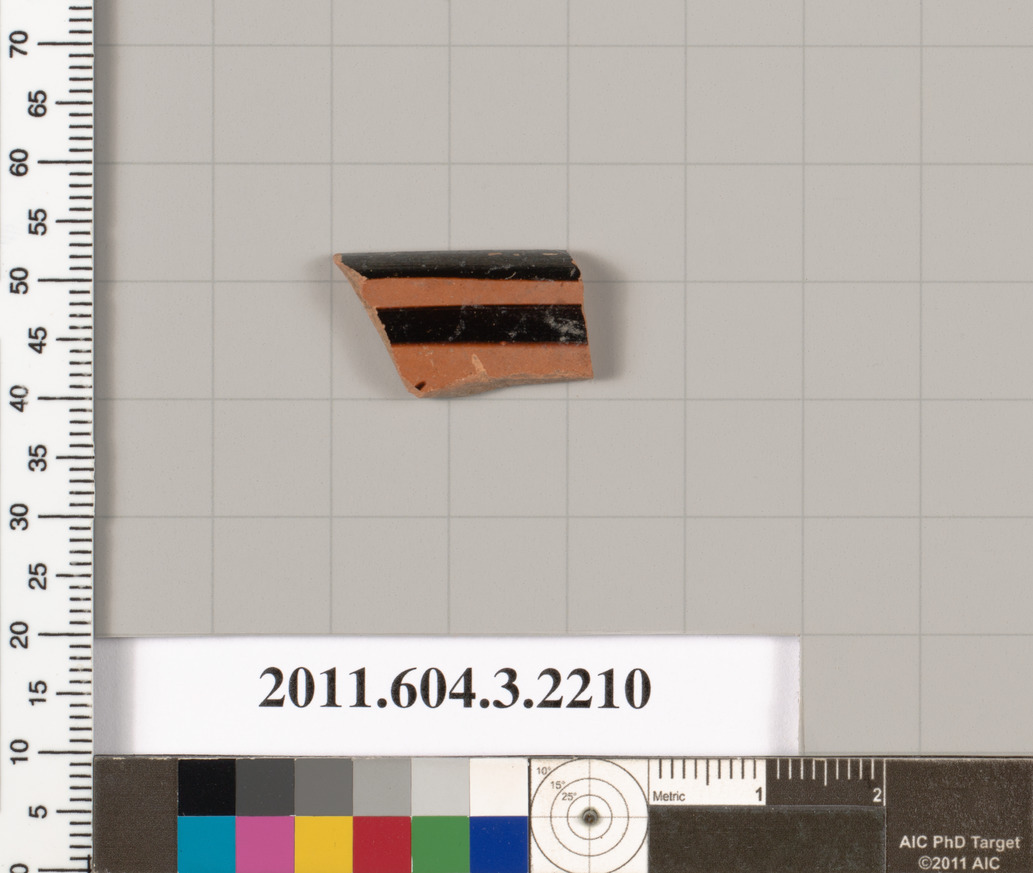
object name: kylix fragment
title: Terracotta fragment of a kylix (drinking cup)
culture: greek, attic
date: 600-401 BCE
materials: terracotta